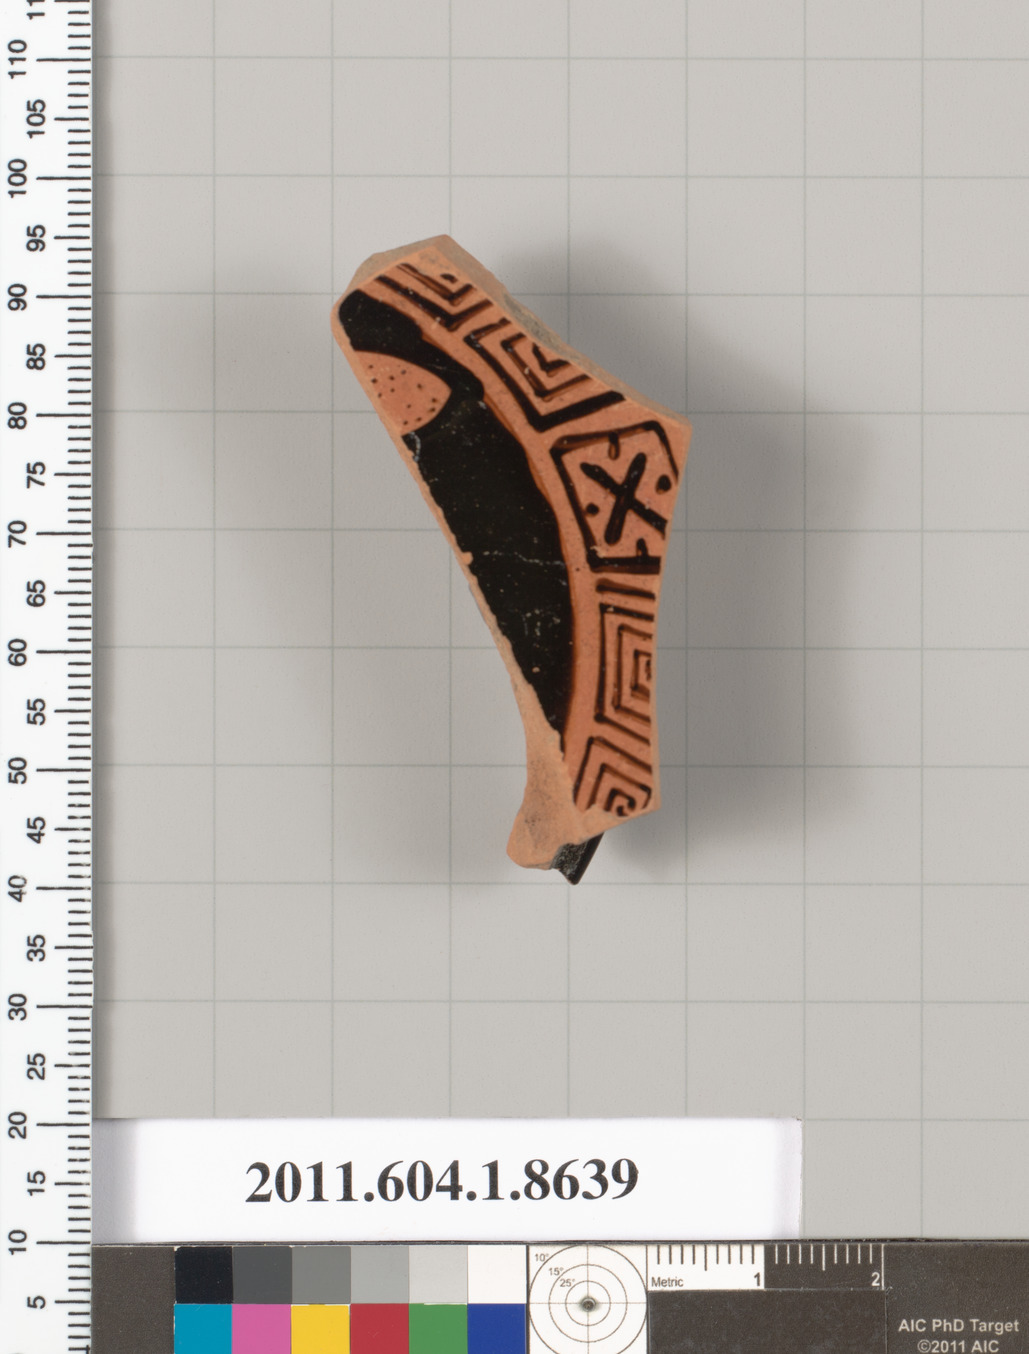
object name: kylix fragment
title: Terracotta fragment of a stemless kylix (drinking cup)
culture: greek, attic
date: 467-435 BCE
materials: terracotta